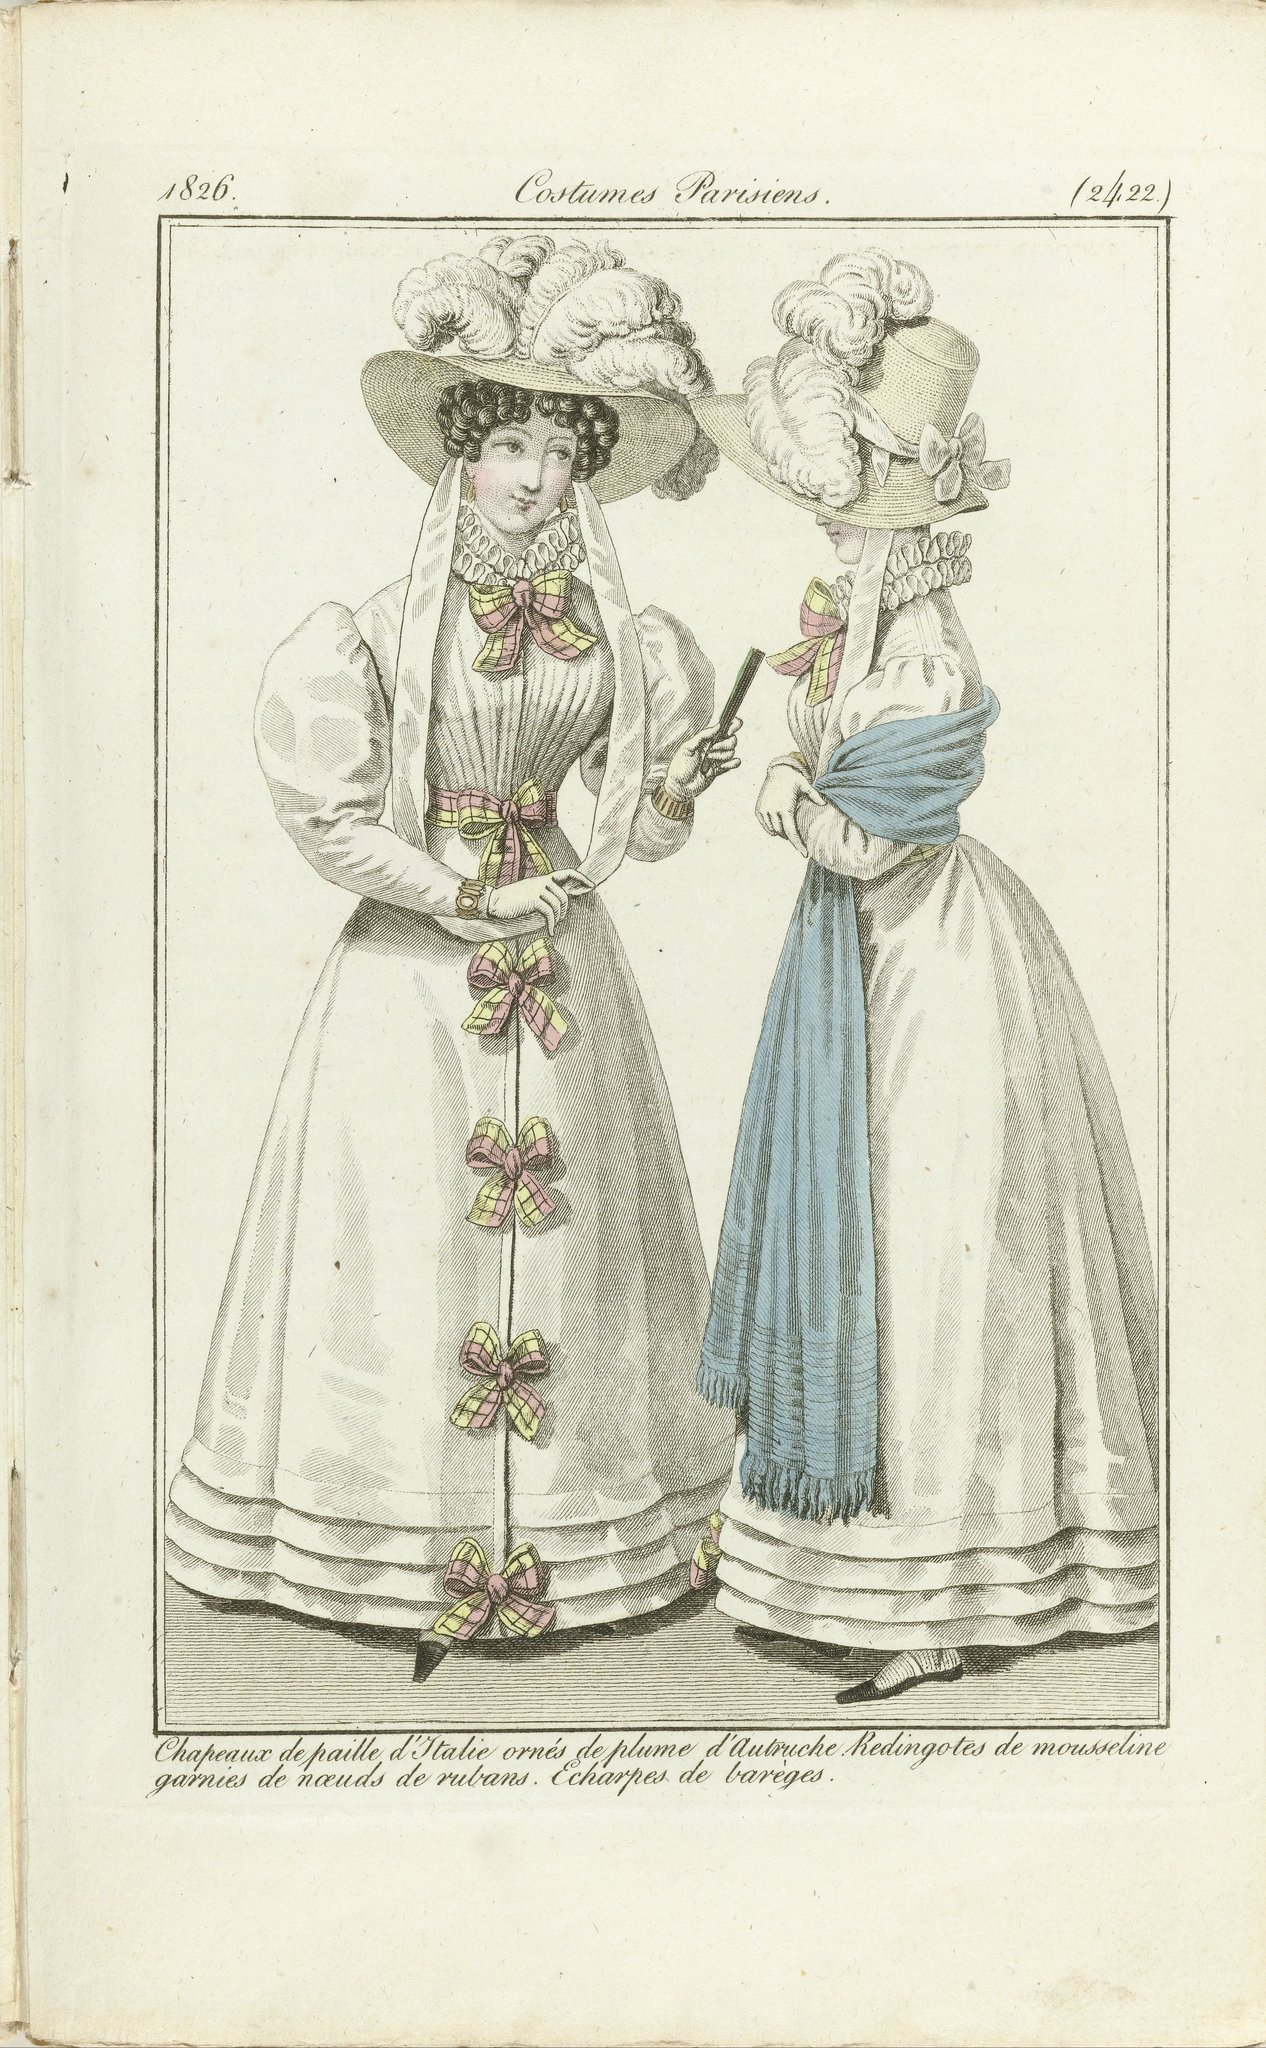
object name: fashion print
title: Journal des dames et des modes 1826, Costumes Parisiens (2422)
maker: Anonymous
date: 1826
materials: paper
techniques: etching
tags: fashion plates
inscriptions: date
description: Chapeaux de paille d'Italie orné de plume d'Autruche. Redingotes de mousseline garnies de noeuds de rubans. Echarpes de barèges.